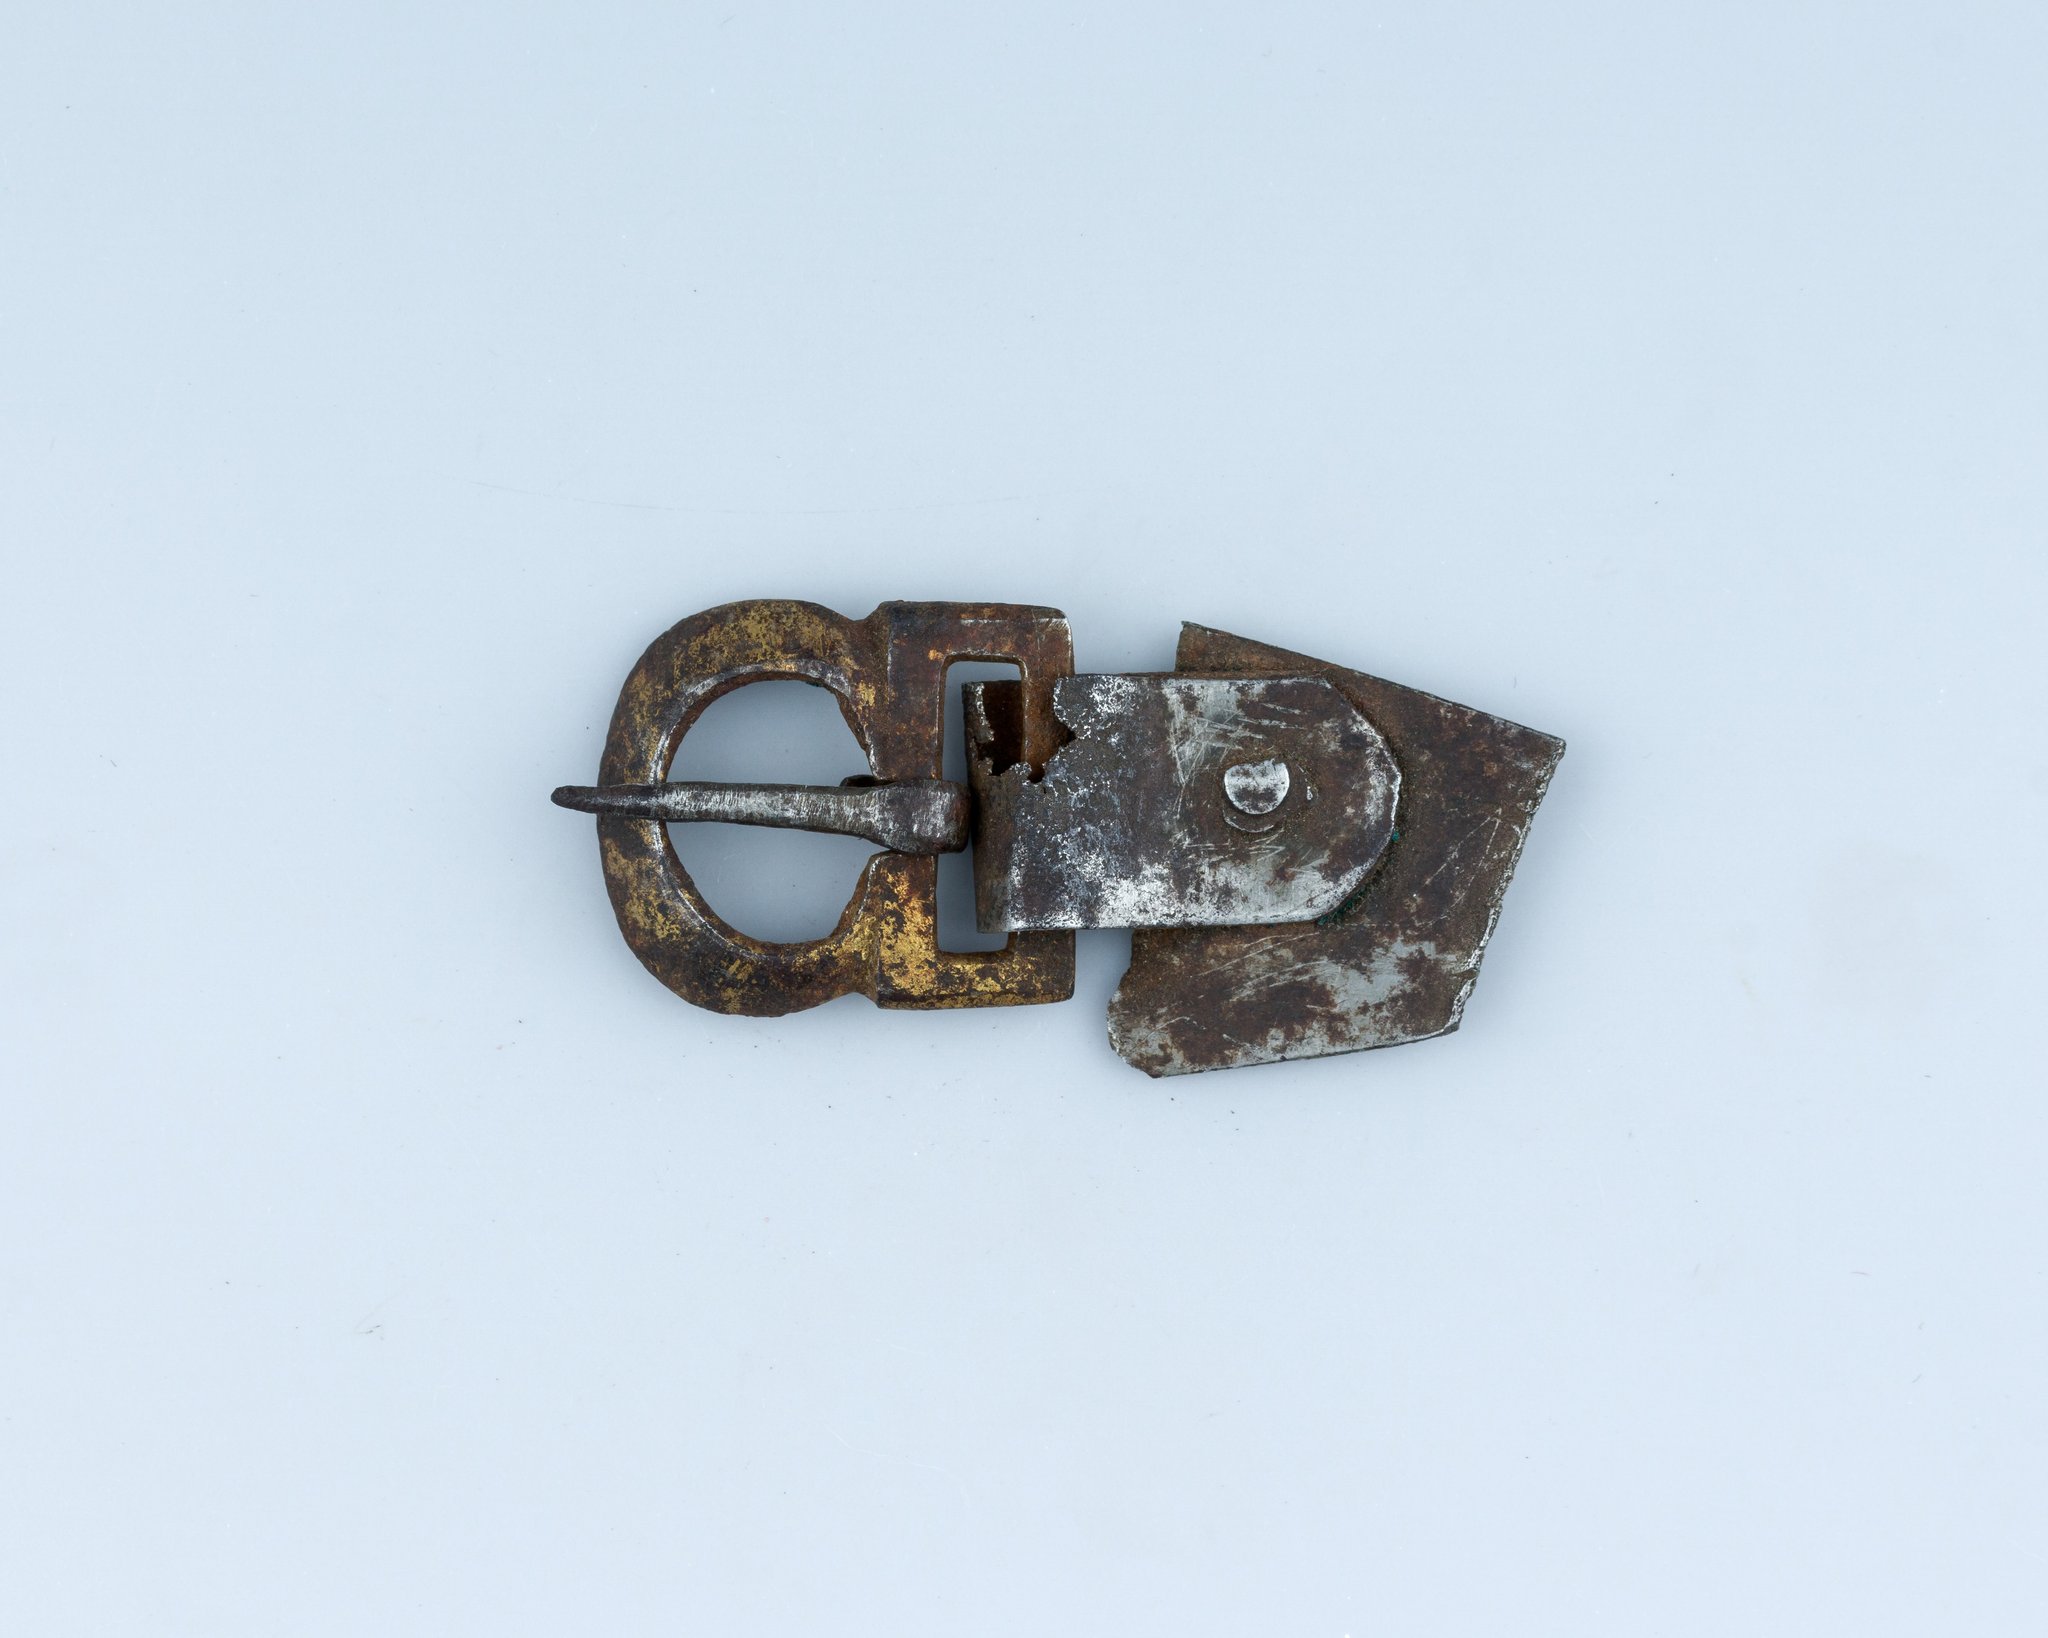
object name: buckle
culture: european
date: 1401-1700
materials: gilt, steel